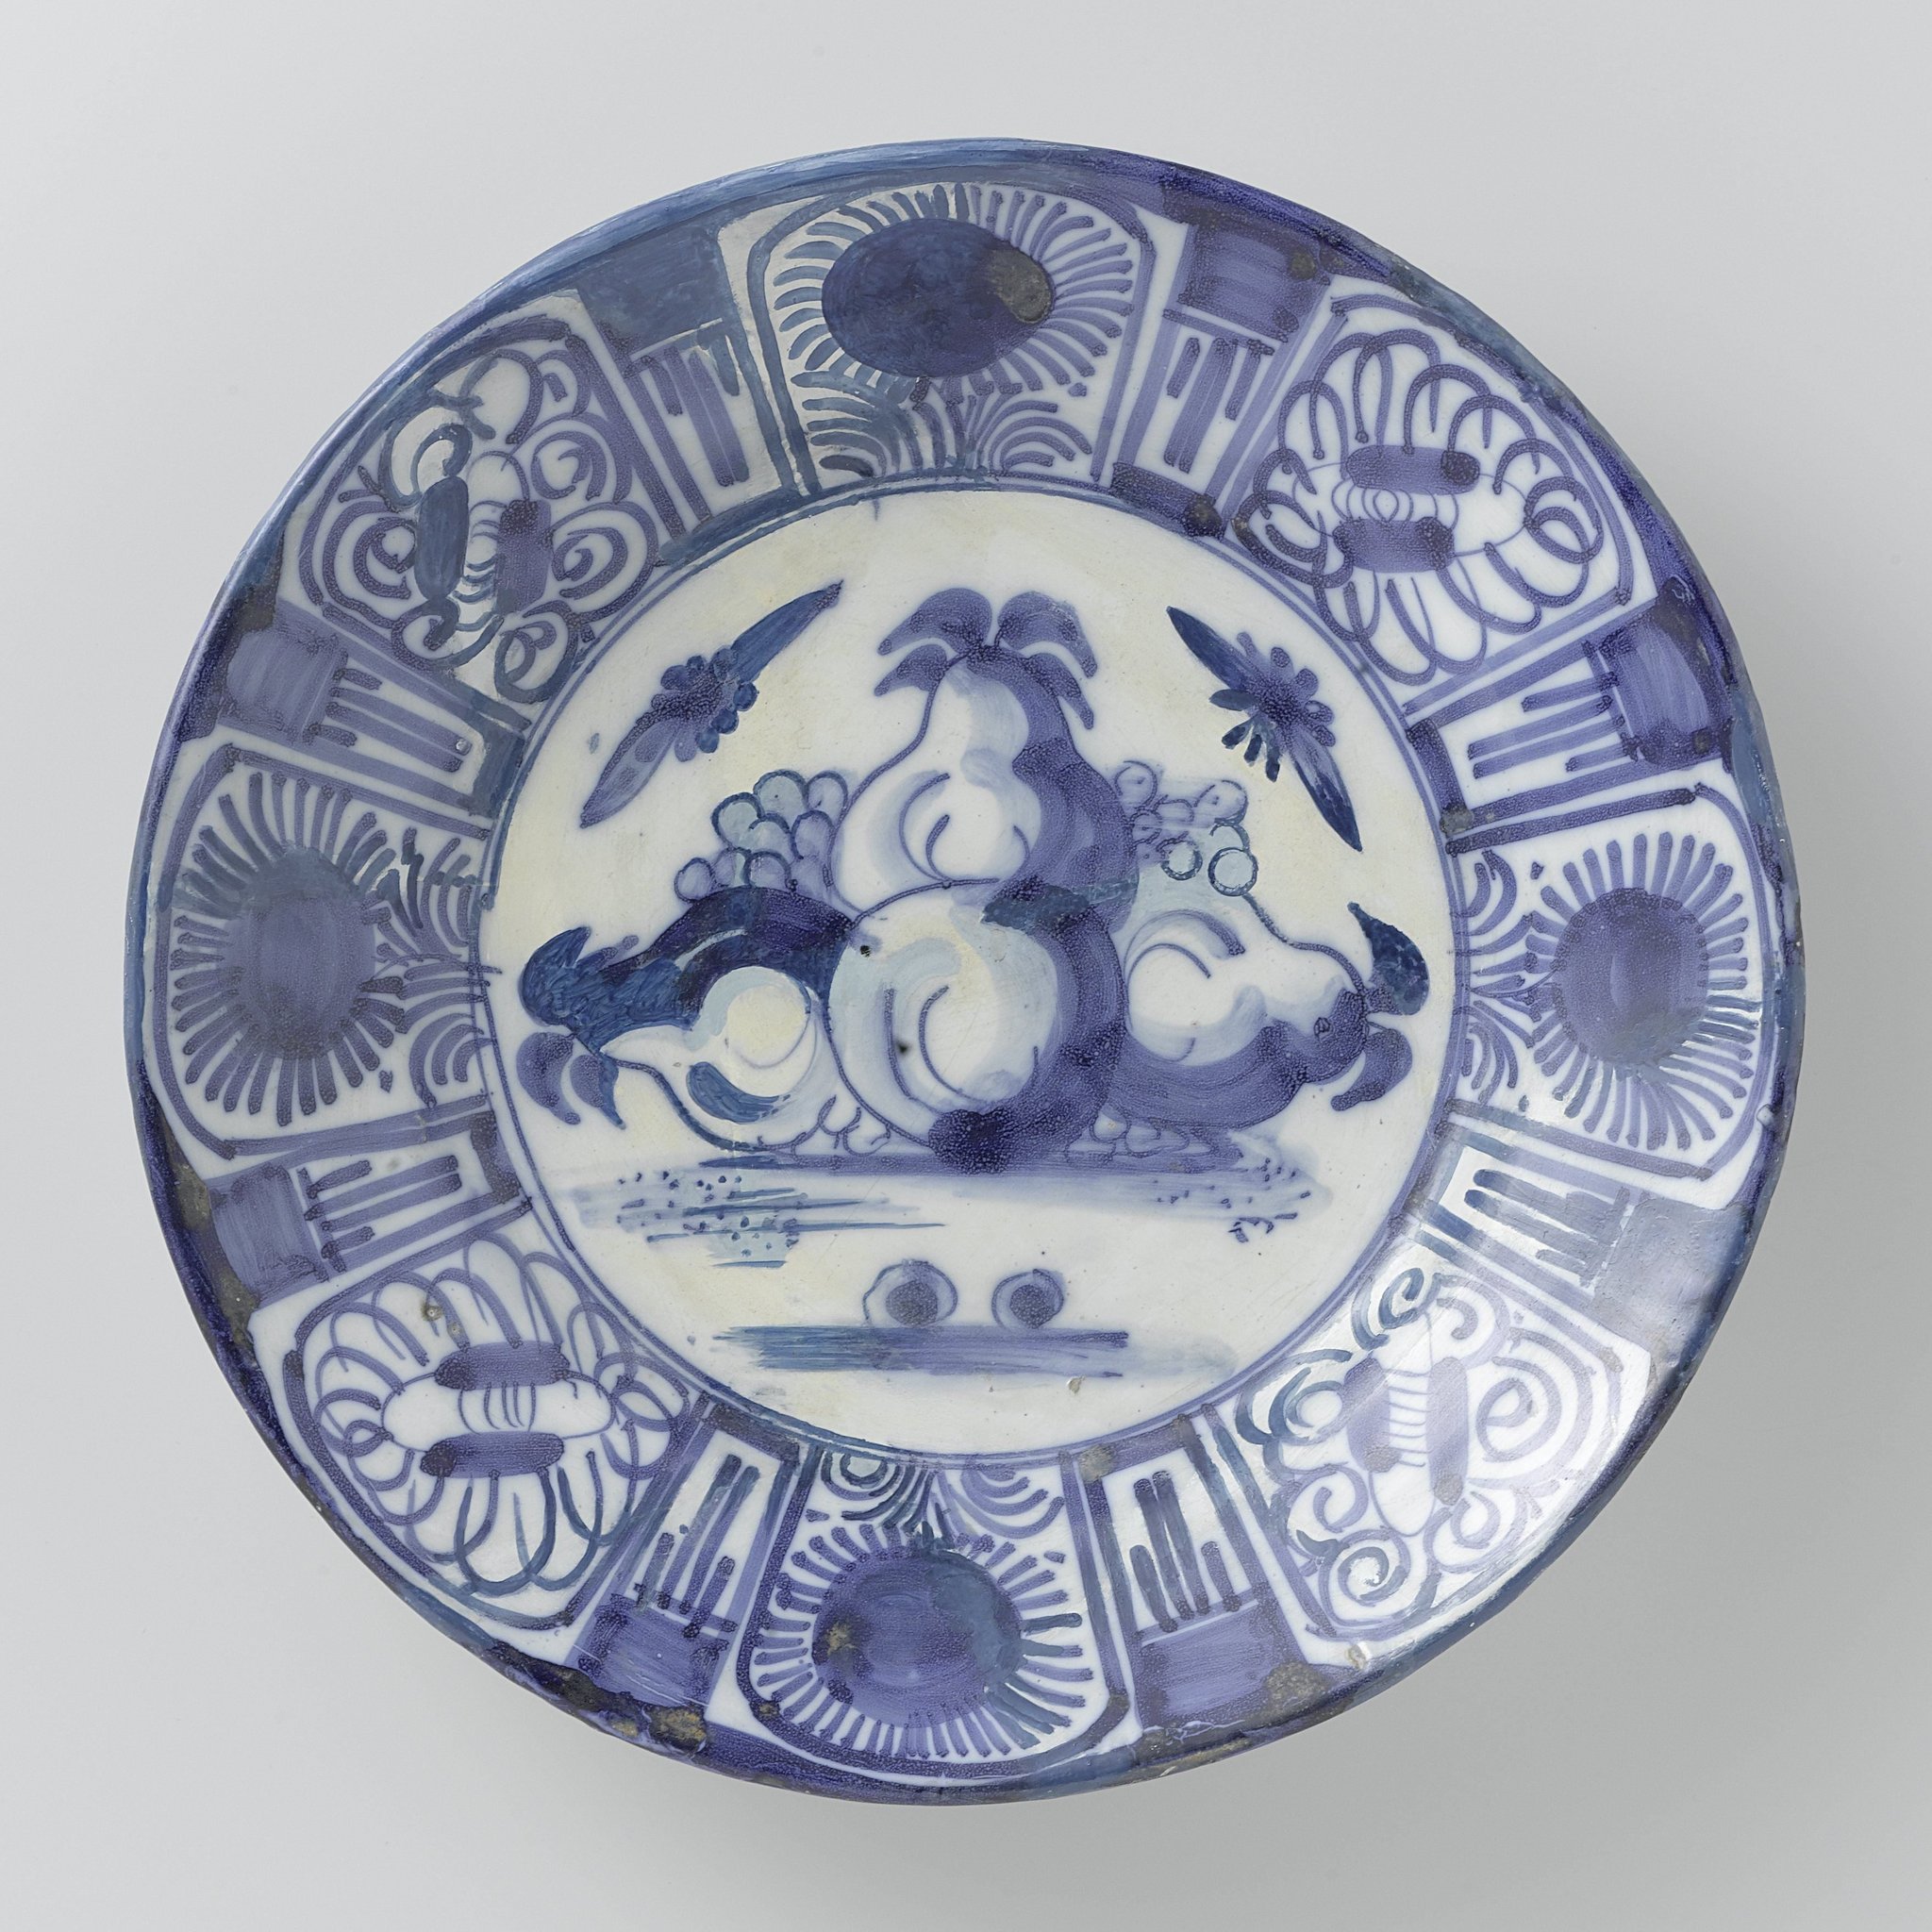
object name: platter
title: Schotel, op het plat beschilderd met vier peren op een grond. Randversiering met Wan Li decor in vakken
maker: Anonymous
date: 1650-1670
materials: earthenware, glaze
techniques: painted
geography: delft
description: Ronde schotel van blauw beschilderde faience. Op het plat zijn vier peren op een grond geschilderd. Op de rand zijn acht vakken waarin een gestileerde bloem geschilderd (Wan Li). Het bord is een bodemvondst. De rand is aangevuld en gerestaureerd.